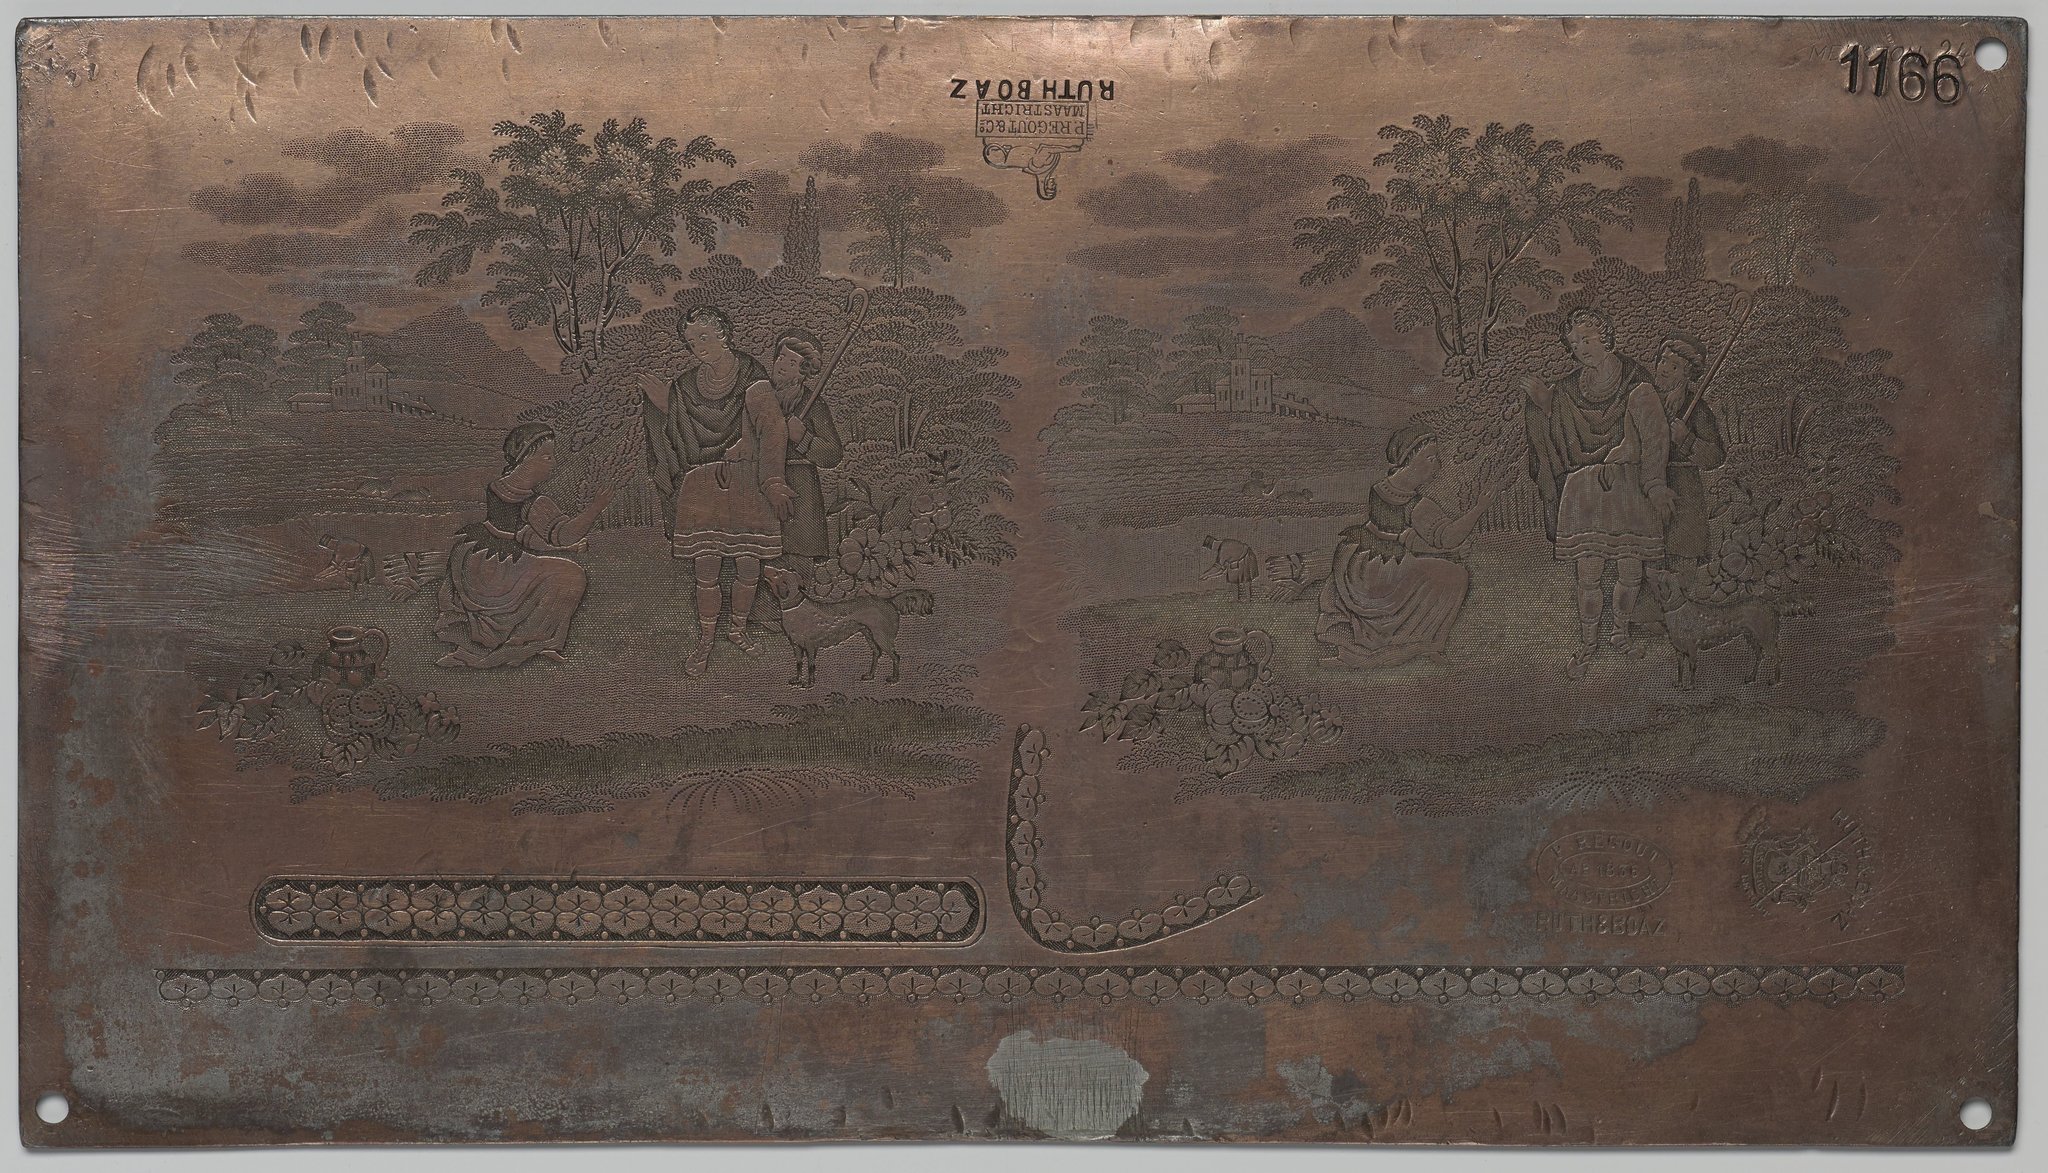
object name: plate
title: Plaat met gegraveerde decoraties voor aardewerk: "middenstuk No 3 CHINEES ZWART"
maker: petrus regout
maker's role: plateelbakker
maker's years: 1801-1879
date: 1801-1879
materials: copper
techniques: engraving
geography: maastricht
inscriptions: inscription: ‘992’, inscription: ‘middenstuk No 3 CHINEES ZWART’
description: Plaat van koper met gegraveerde voorstellingen voor "middenstuk No 3 CHINEES ZWART", met onder andere een huis, een vogel en bloemen. In drie hoeken van de plaat geboorde gaten. De achterzijde van de plaat heeft draagt het nummer 992.